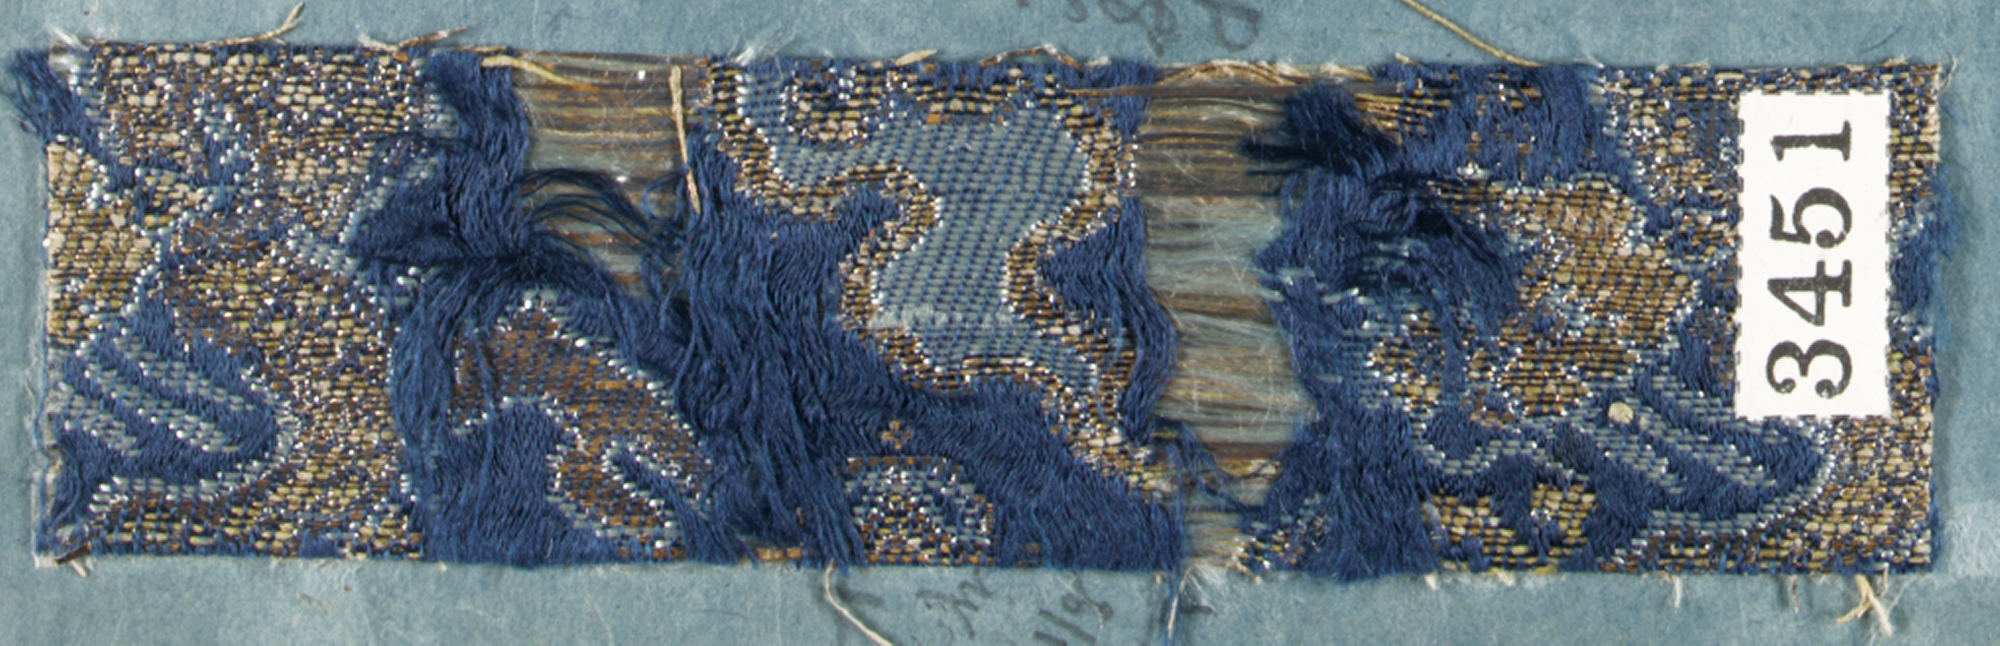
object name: sample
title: Textile Sample from Sample Book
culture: japanese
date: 1801-1900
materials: silk